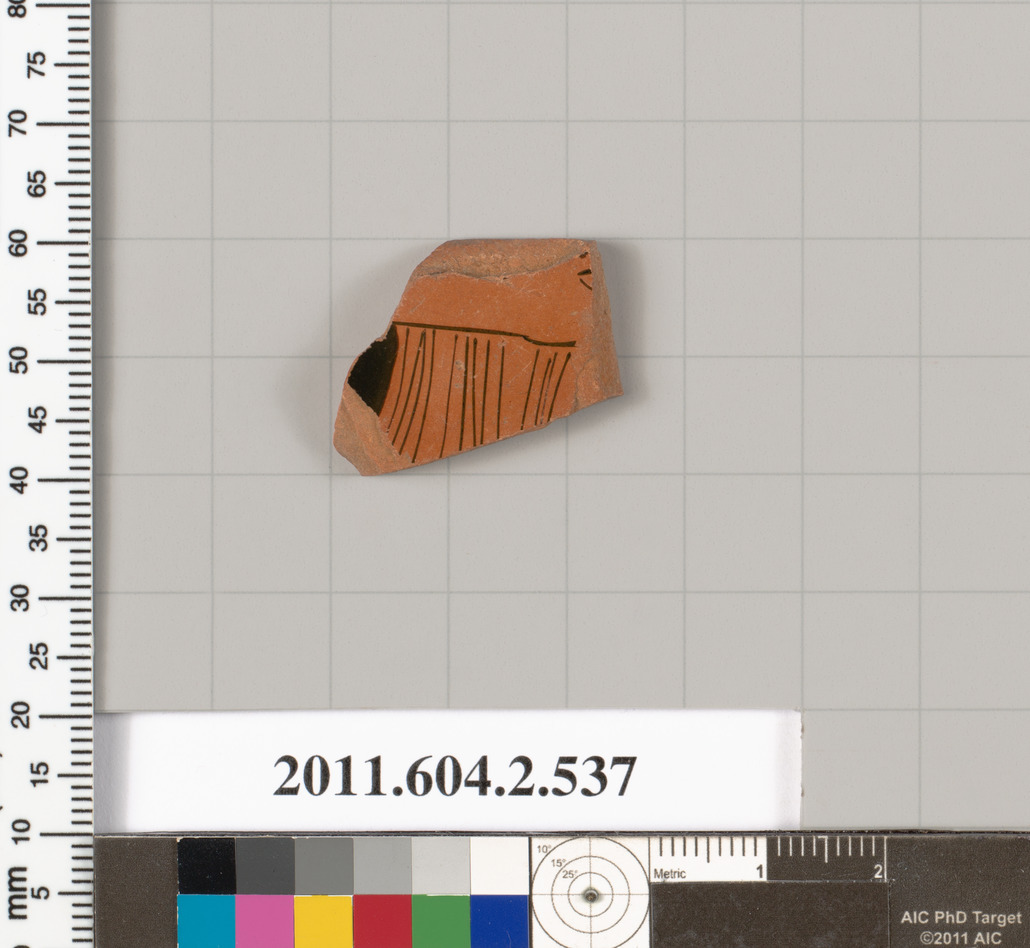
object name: column krater fragment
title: Terracotta fragment of a column-krater (bowl for mixing wine and water)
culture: greek, attic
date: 460-440 BCE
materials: terracotta